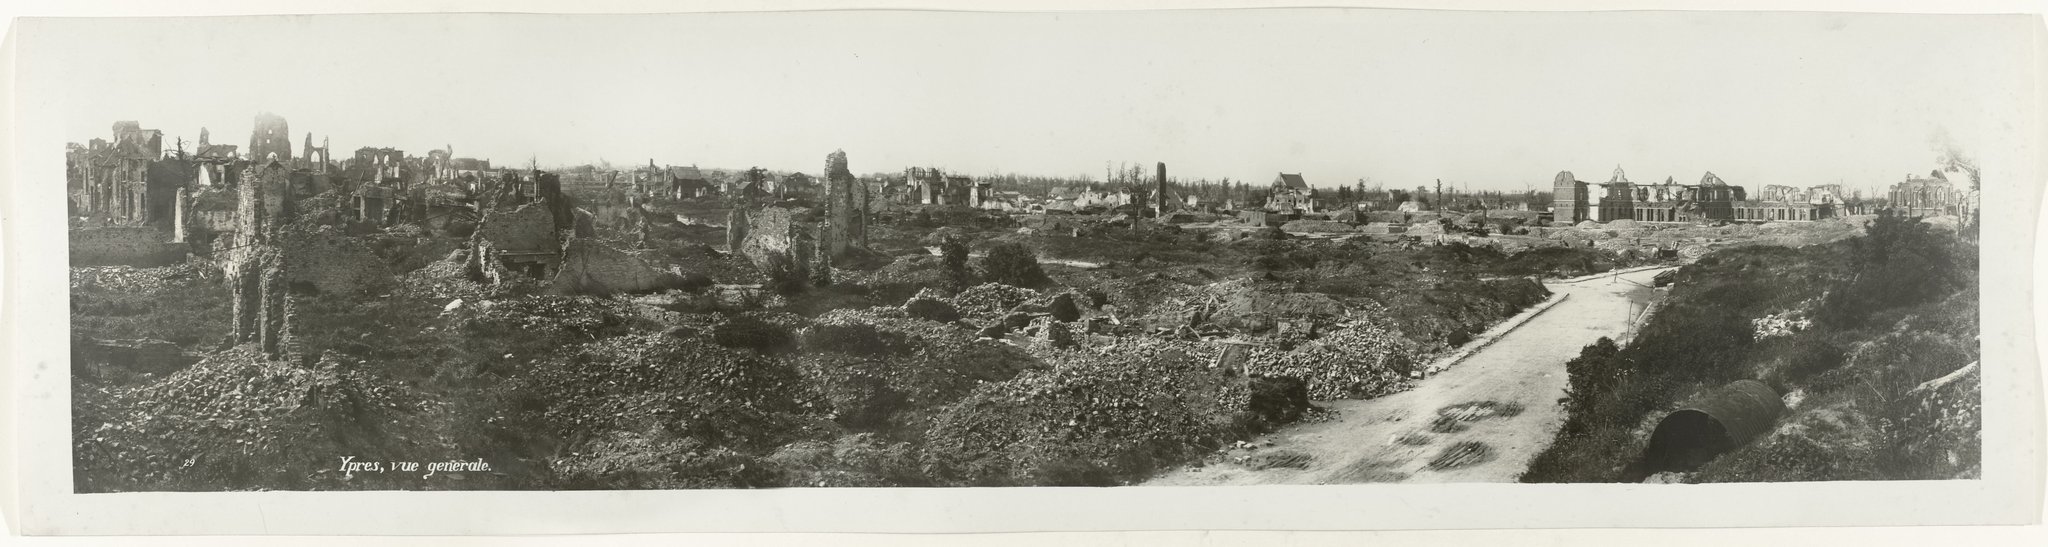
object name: photograph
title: Ruines de Lille (Ruins of Lille) Ypres, vue generale (View of Ypres/Ieper)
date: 1918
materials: photographic support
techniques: gelatin silver print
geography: ieper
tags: devastated, ruined place or city (~ warfare)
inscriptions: annotation: ‘29 // Ypres, vue generale.’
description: The industrial mechanised manner of warfare in the First World War wrought unprecedented destruction. Cities such as Lille suffered severe damage. The Belgium town of Ieper (Ypres) had been in the frontline for four years and was almost completely destroyed. This devastation was captured in panoramic images. The initial clearing up of the debris can be seen in both photographs.